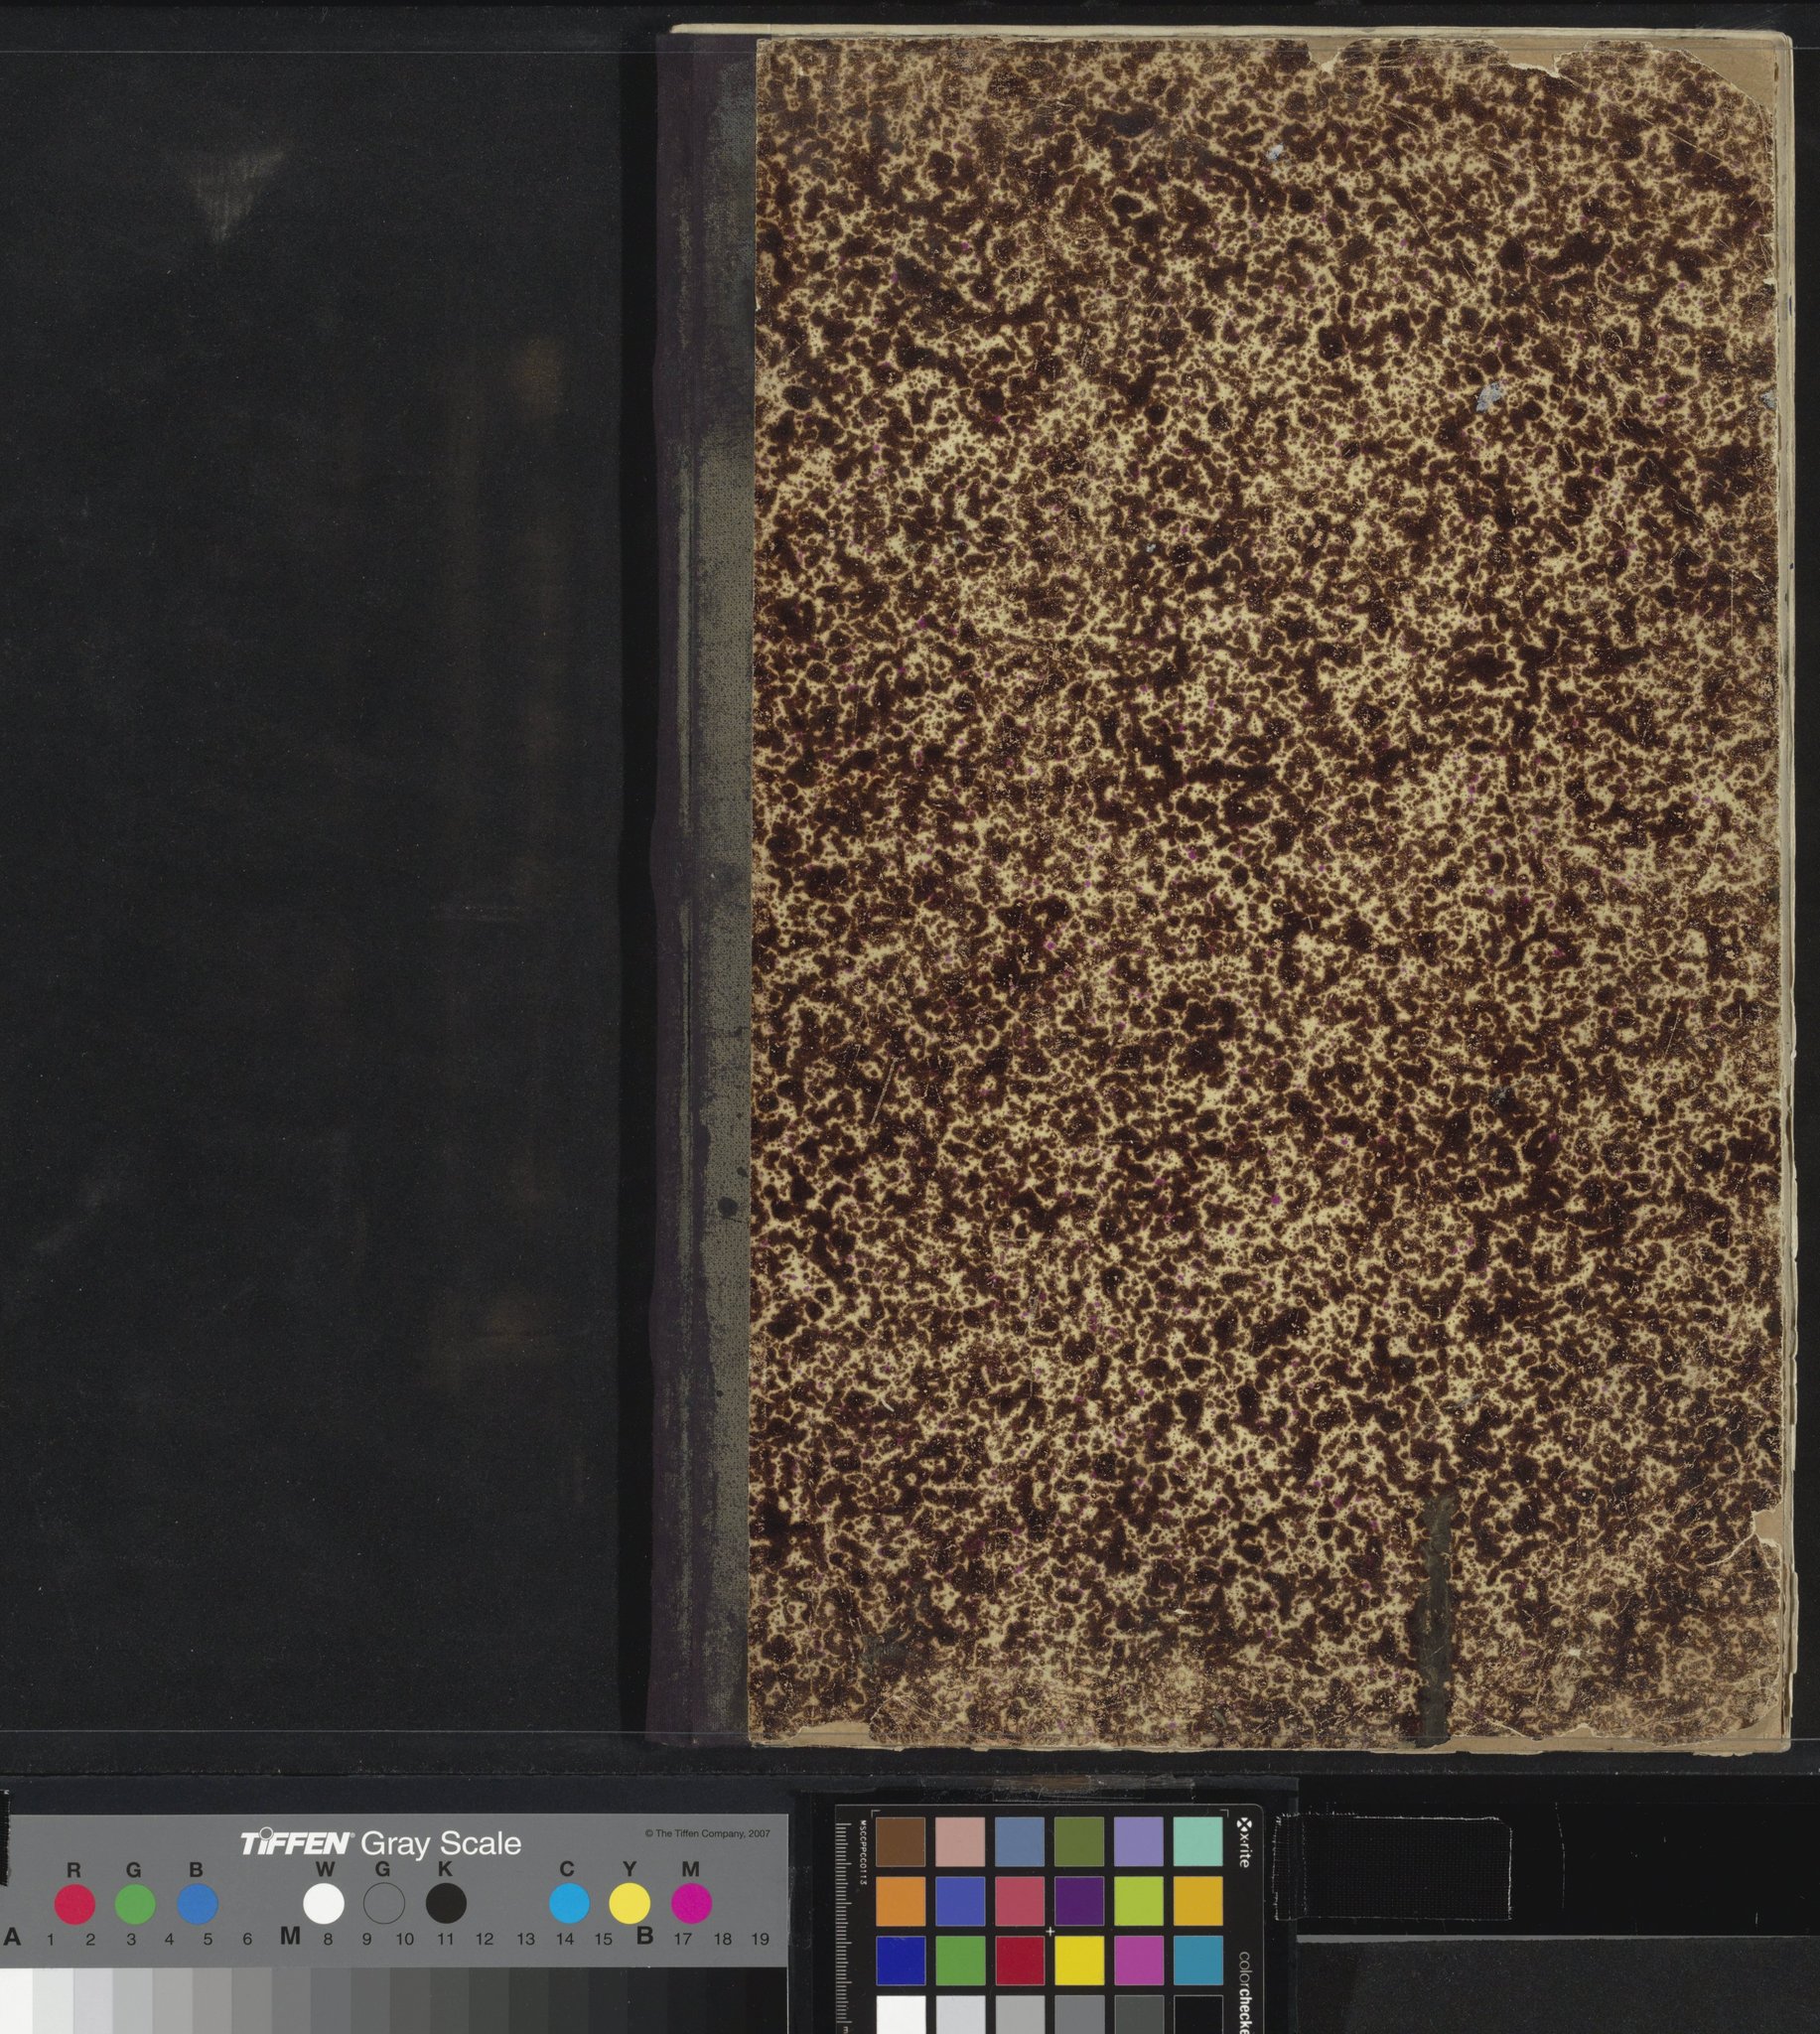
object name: sketchbook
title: Schetsboek LXIX met 25 bladen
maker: isaac israels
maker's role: draughtsman, painter, print maker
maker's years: 1865-1934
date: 1875-1934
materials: cardboard, chalk, linen, paper, watercolor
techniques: brush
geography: the hague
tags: chess, sewing, donkey-riding (on the beach)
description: Schetsboek nr. LXIX bestaande uit 25 bladen met naaisters, schakers, vrouwelijke naakten en een zittend meisje.